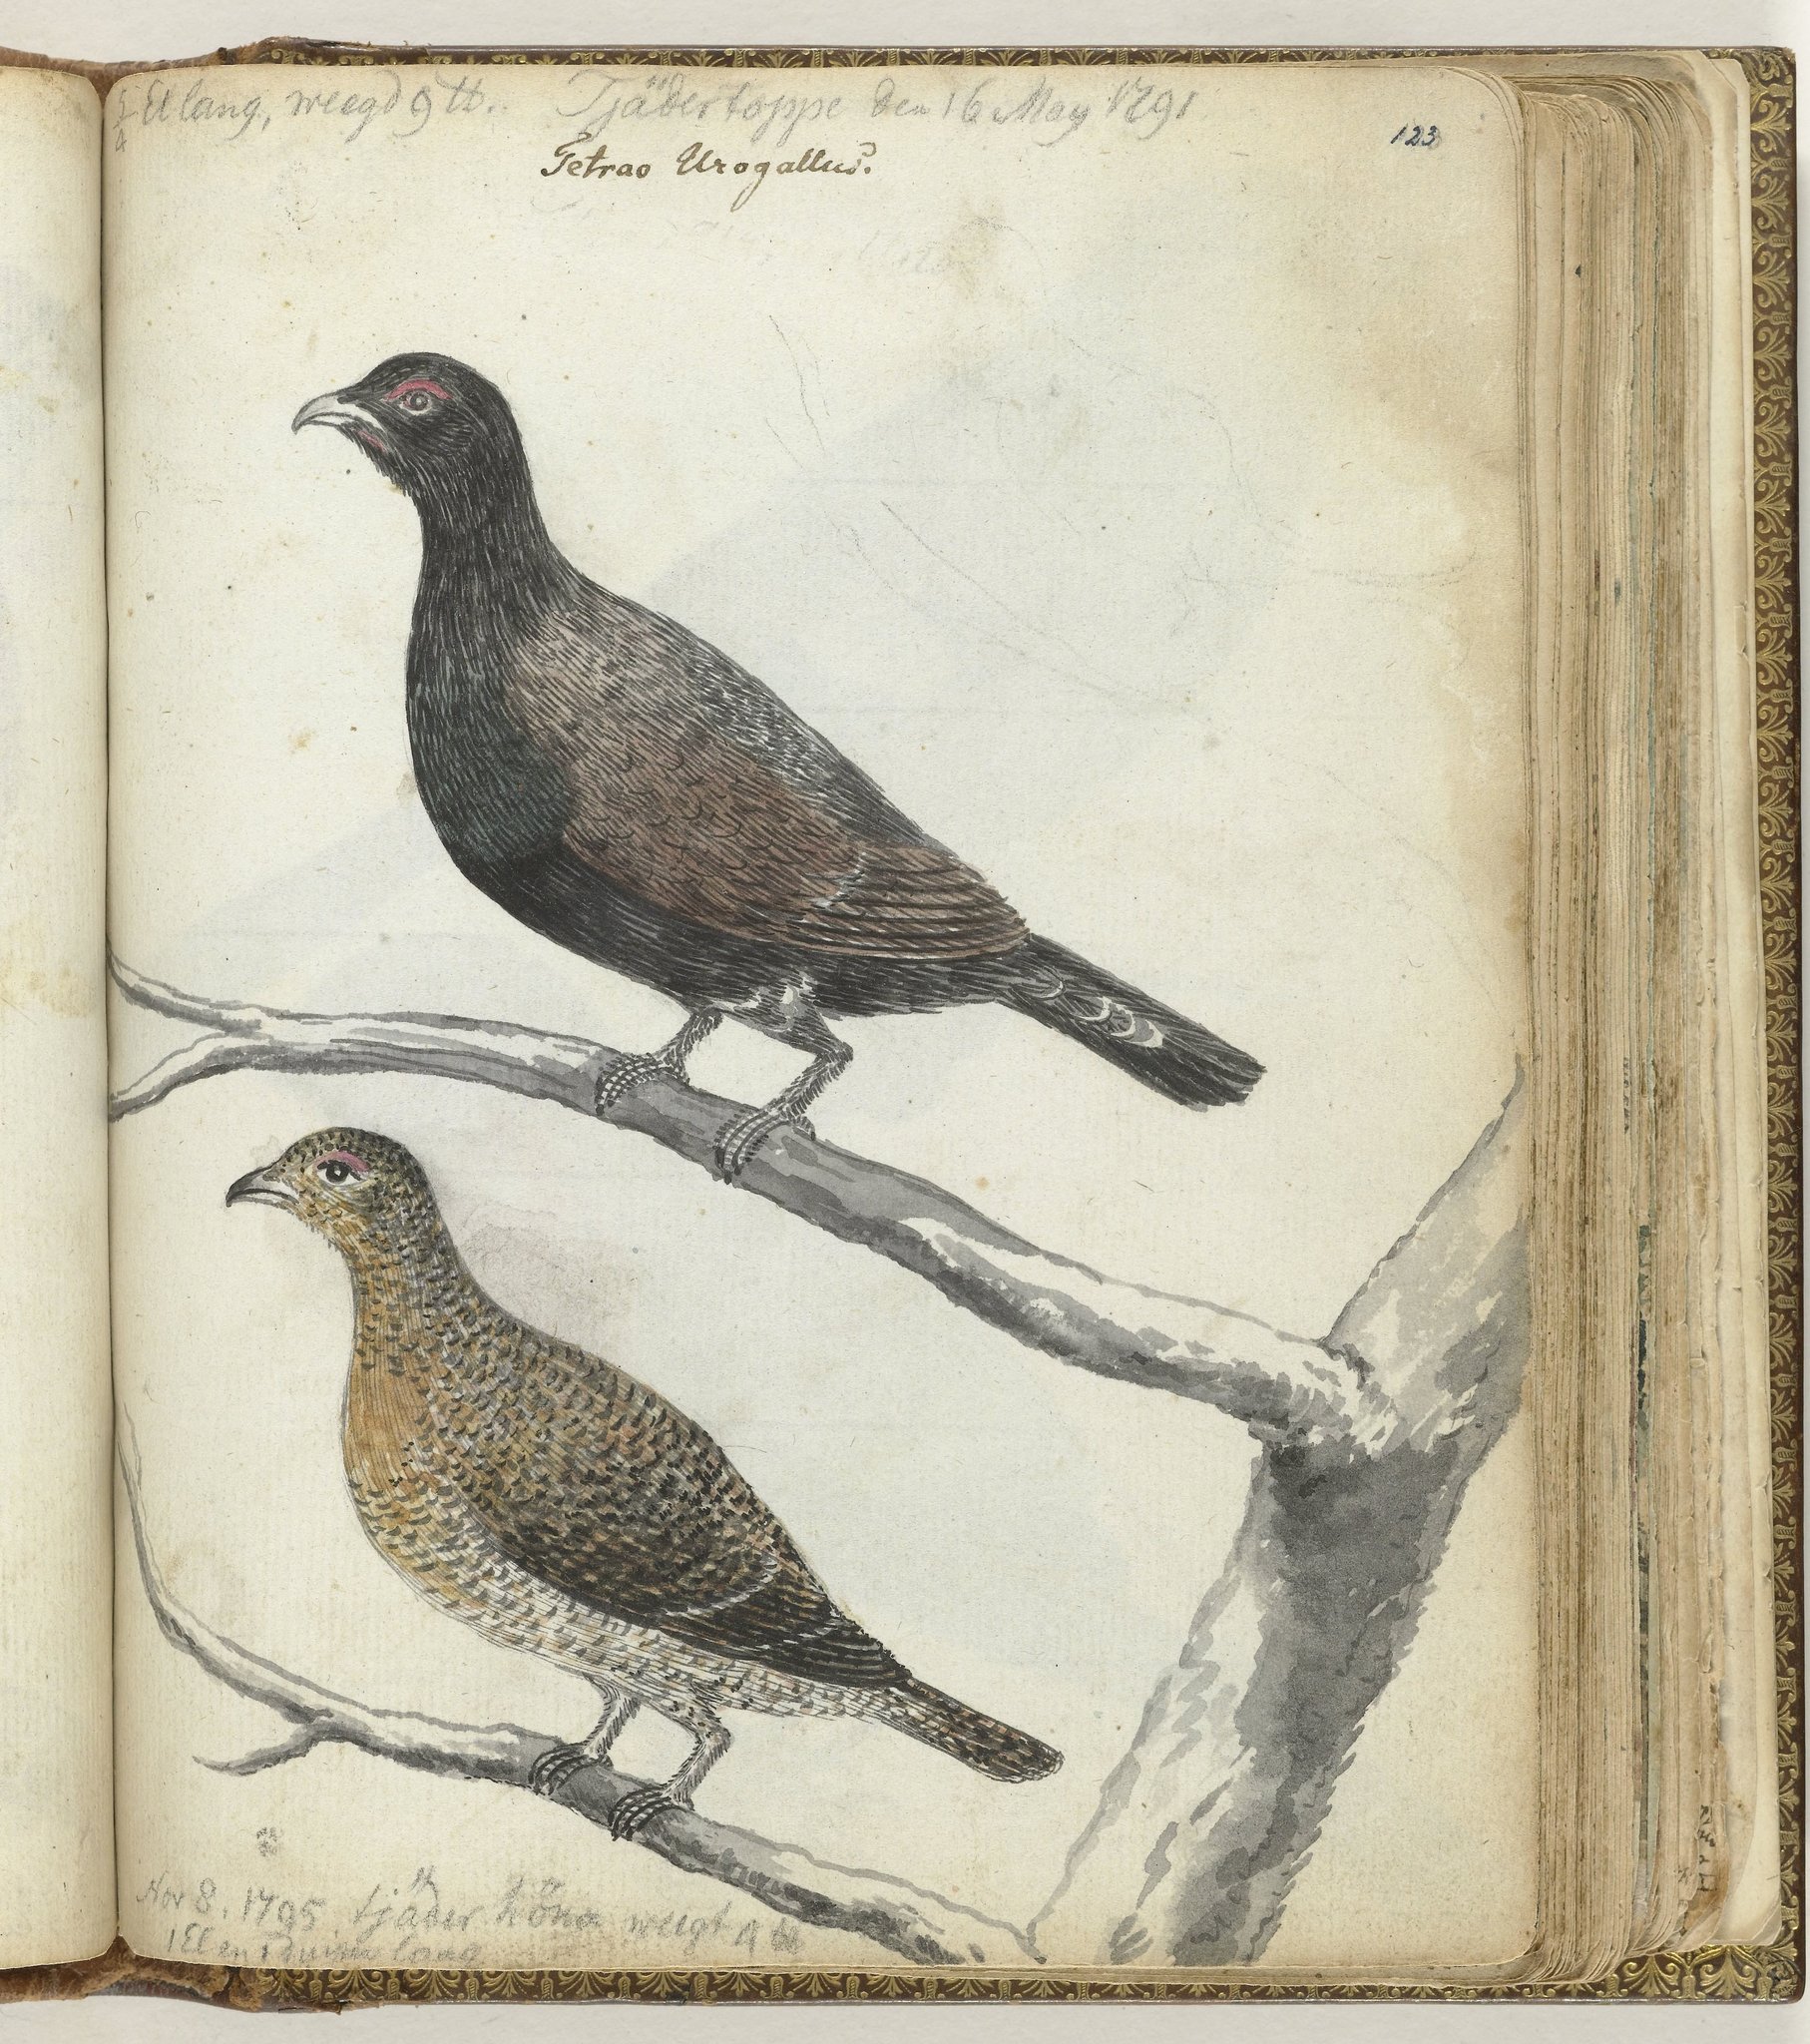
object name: drawing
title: Zweedse vogels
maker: jan brandes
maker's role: draughtsman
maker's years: 1743-1808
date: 1791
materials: paper, pencil, watercolor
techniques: brush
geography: karlberg palace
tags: birds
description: Kleurtekening van een korhoenachtige en een fazantachtige vogel. Met opschrift. Onderdeel uit het schetsboek van Jan Brandes, dl. 1 (1808), p. 123.